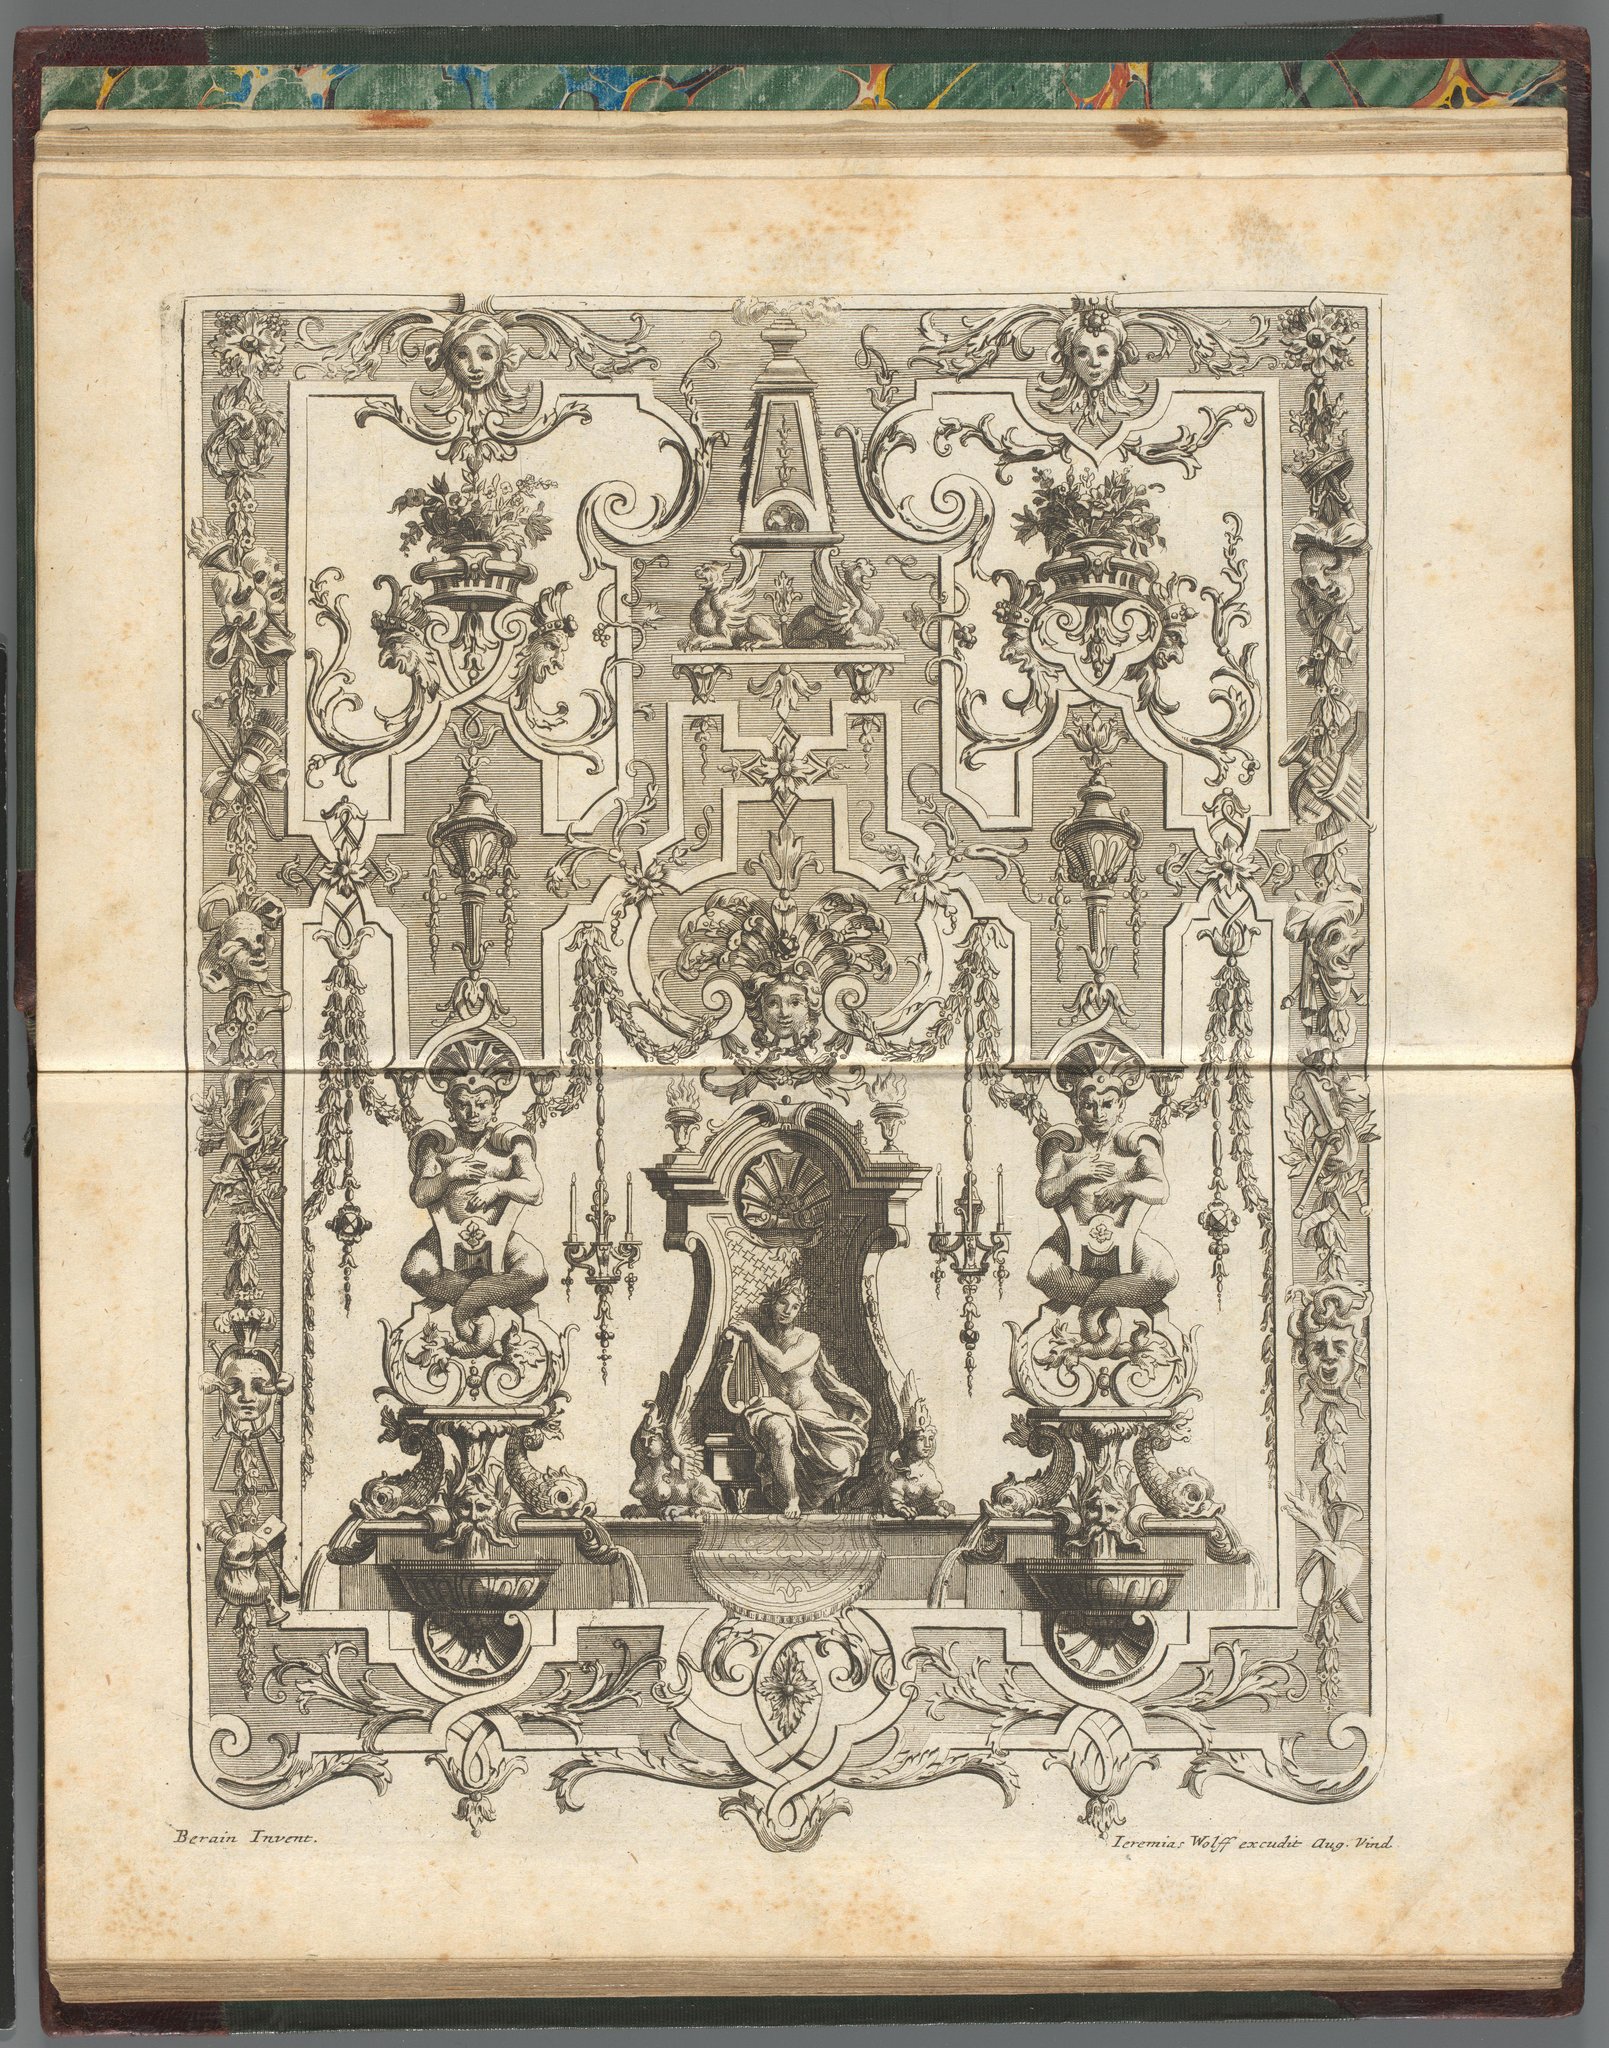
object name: ornament print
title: Compositie met Apollo op troon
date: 1686-1724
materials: paper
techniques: etching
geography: augsburg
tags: ornaments ~ art, floral interlace ~ ornament, triton(s), (story of) apollo (phoebus), throne, harp, mask, mascaron ~ ornament, ornament ~ festoon, garland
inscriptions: signature: ‘Ieremias Wolff excudit Aug. Vind.’, signature: ‘Berain Invent.’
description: Een decoratieve compositie met vlechtwerk en in het midden Apollo op een troon met een harp. Apollo wordt geflankeerd door twee tritons gevangen in rolwerk. Het geheel wordt geflankeerd door twee hangende festoens met maskers en muziekinstrumenten. Prent maakt deel uit van een album. Hoogstwaarschijnlijk gespiegelde kopie naar Frans origineel.